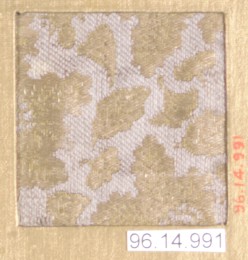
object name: piece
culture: japanese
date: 1701-1900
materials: silk